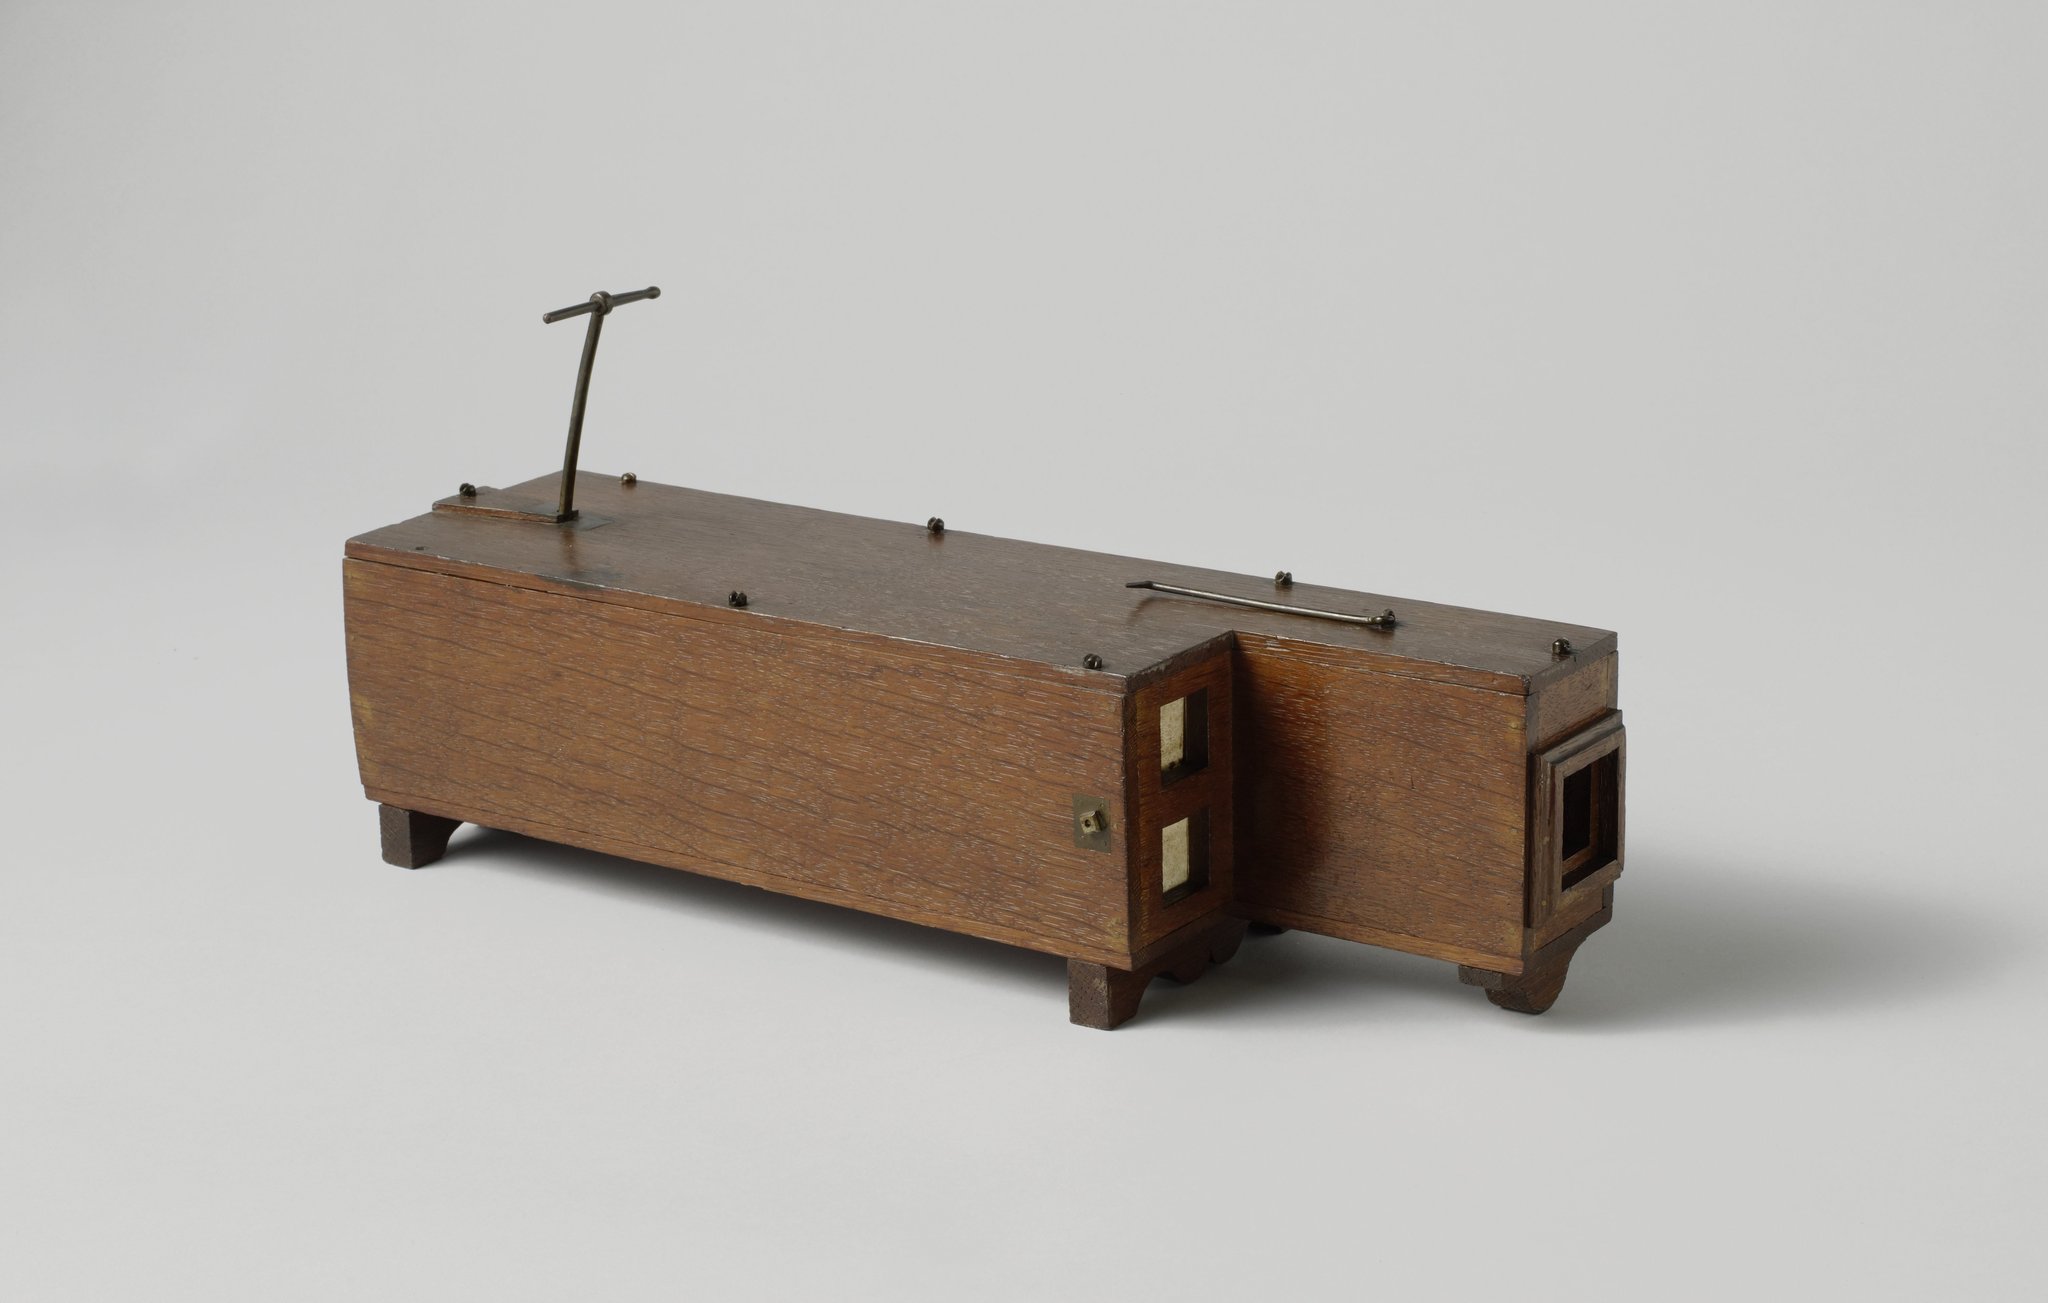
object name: demonstration model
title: Model of a Ventilator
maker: Anonymous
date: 1800-1850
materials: brass, leather, wood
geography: netherlands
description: Model van een ventilator, werkend als een dubbele blaasbalg. In het grote rechthoekige compartiment wordt een plank, die met scharnieren op halve hoogte tegen de korte voorkant is bevestigd, met een hendel op en neer bewogen; de twee helften waarin het compartiment door de plank worden verdeeld worden hierdoor om beurten verkleind en vergroot. Lucht wordt ingelaten door twee vierkante ventielen aan de voorkant, bestaande uit eenvoudige kleppen met zeemleer bekleed, een boven en een beneden de scharnieren van de plank. Door gelijkaardige kleppen wordt de lucht afgevoerd naar een klein compartiment voor, waar de luchtstroom naar een enkele uitgang wordt geleid.